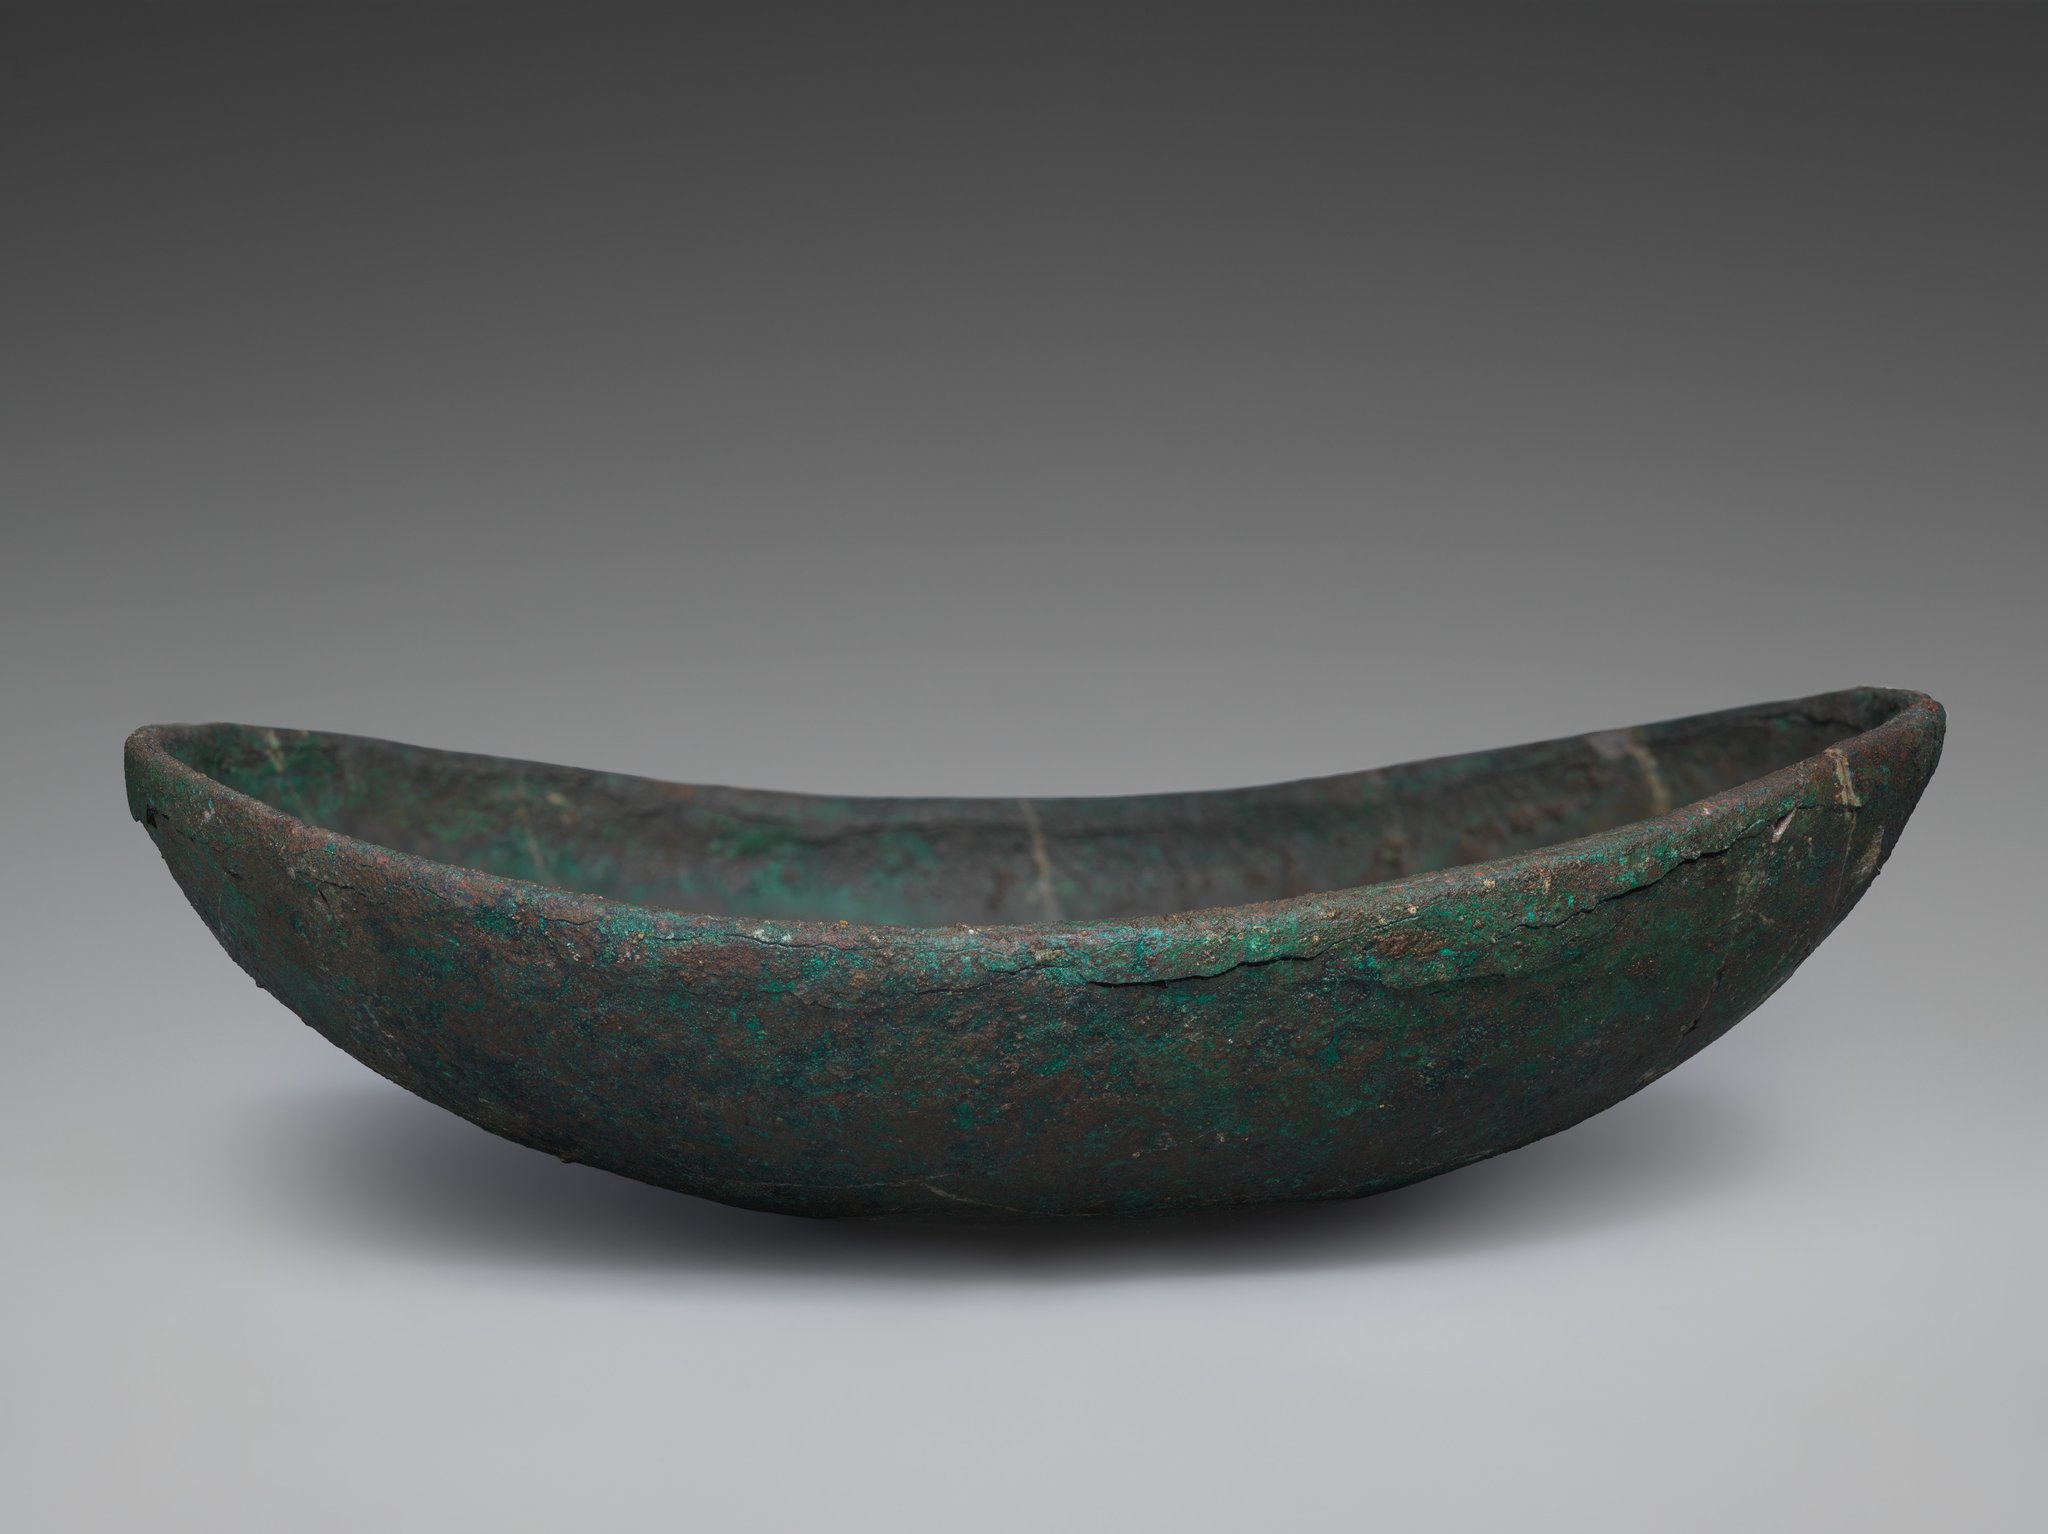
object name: bowl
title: Oval bowl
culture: sasanian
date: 501-700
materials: bronze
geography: iran